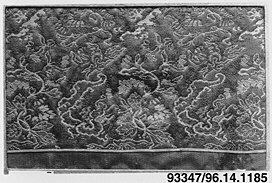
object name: piece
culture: japanese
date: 1701-1900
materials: silk